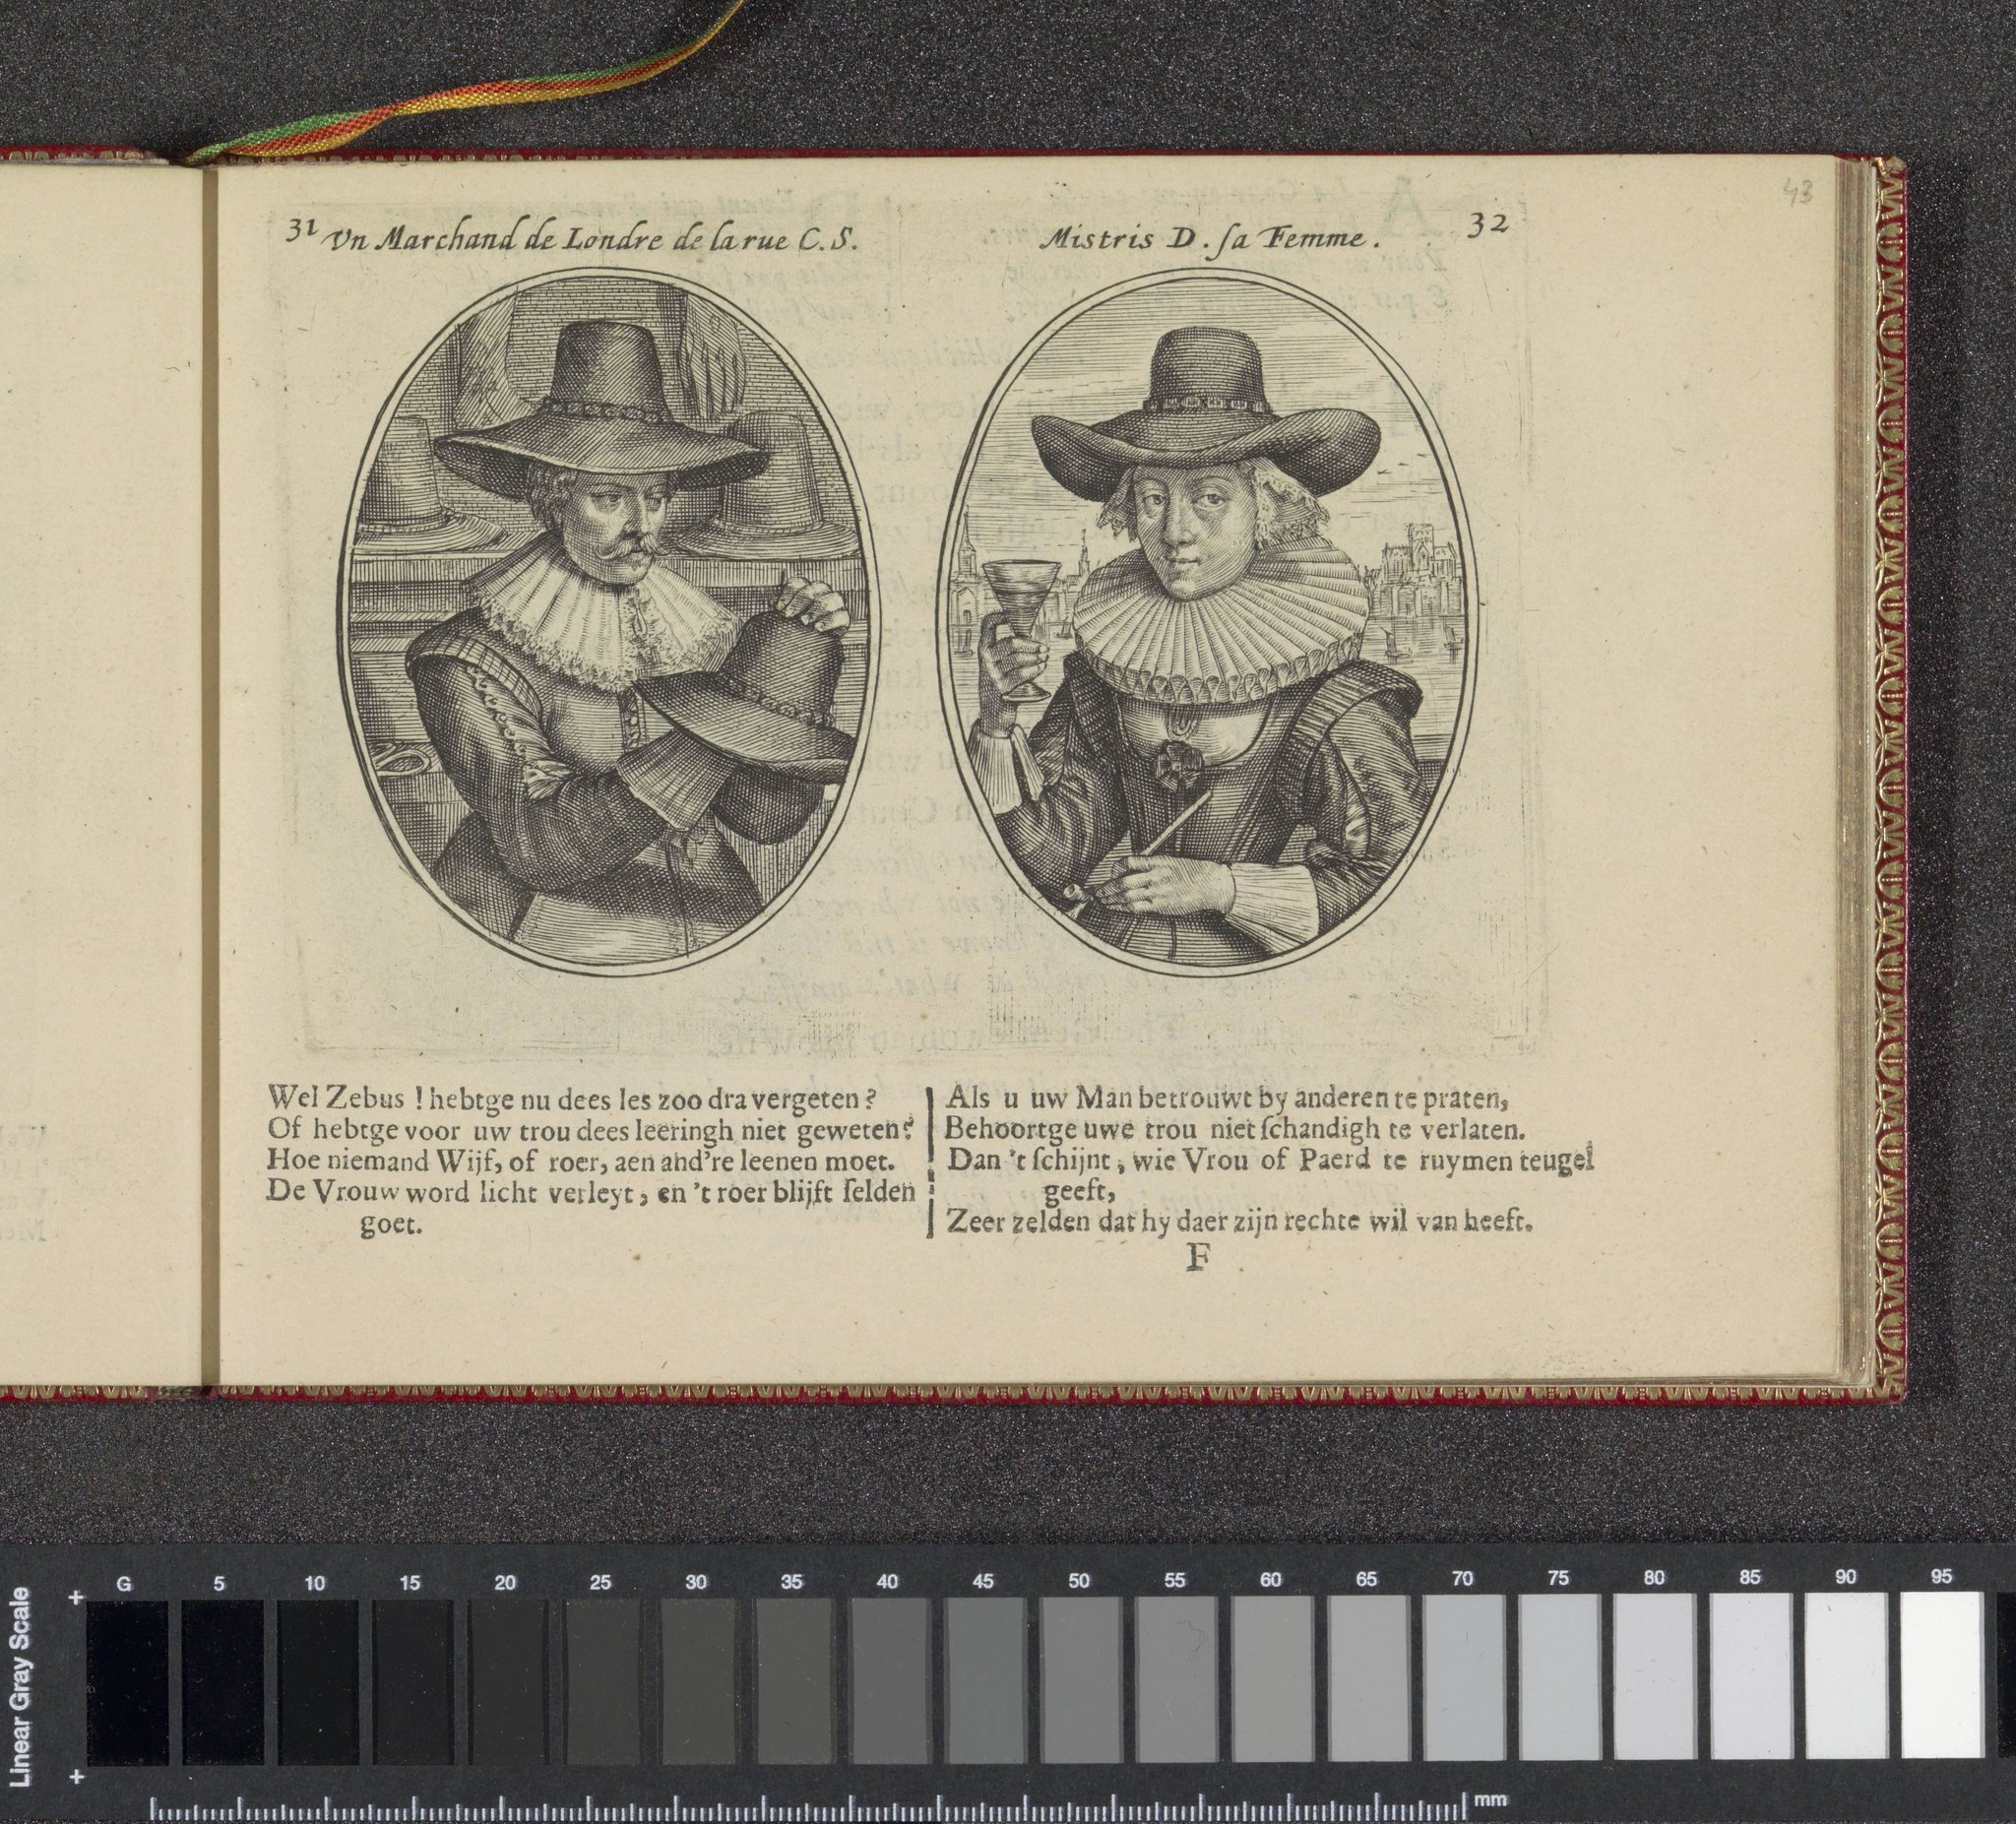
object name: print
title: Un marchand de Londre de la rue C.S. / Mistris D. sa femme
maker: crispijn van de passe (ii)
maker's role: draughtsman, print maker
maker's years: 1594-1670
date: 1641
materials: paper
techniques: engraving, letterpress printing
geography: amsterdam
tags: city-view, and landscape with man-made constructions, head-gear, female sex; woman, pipe ~ tobacco, glass of wine, male sex; man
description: Twee voorstellingen op een albumblad. Links het fictieve portret van een koopman uit Londen. Hij handelt in hoeden, laarzen en handschoenen. Rechts zijn vrouw met wijnglas en tabakspijp. Op de achtergrond de stad Londen en de Theems. Daaronder twee kwatrijnen in het Nederlands. De prent maakt deel uit van een album.